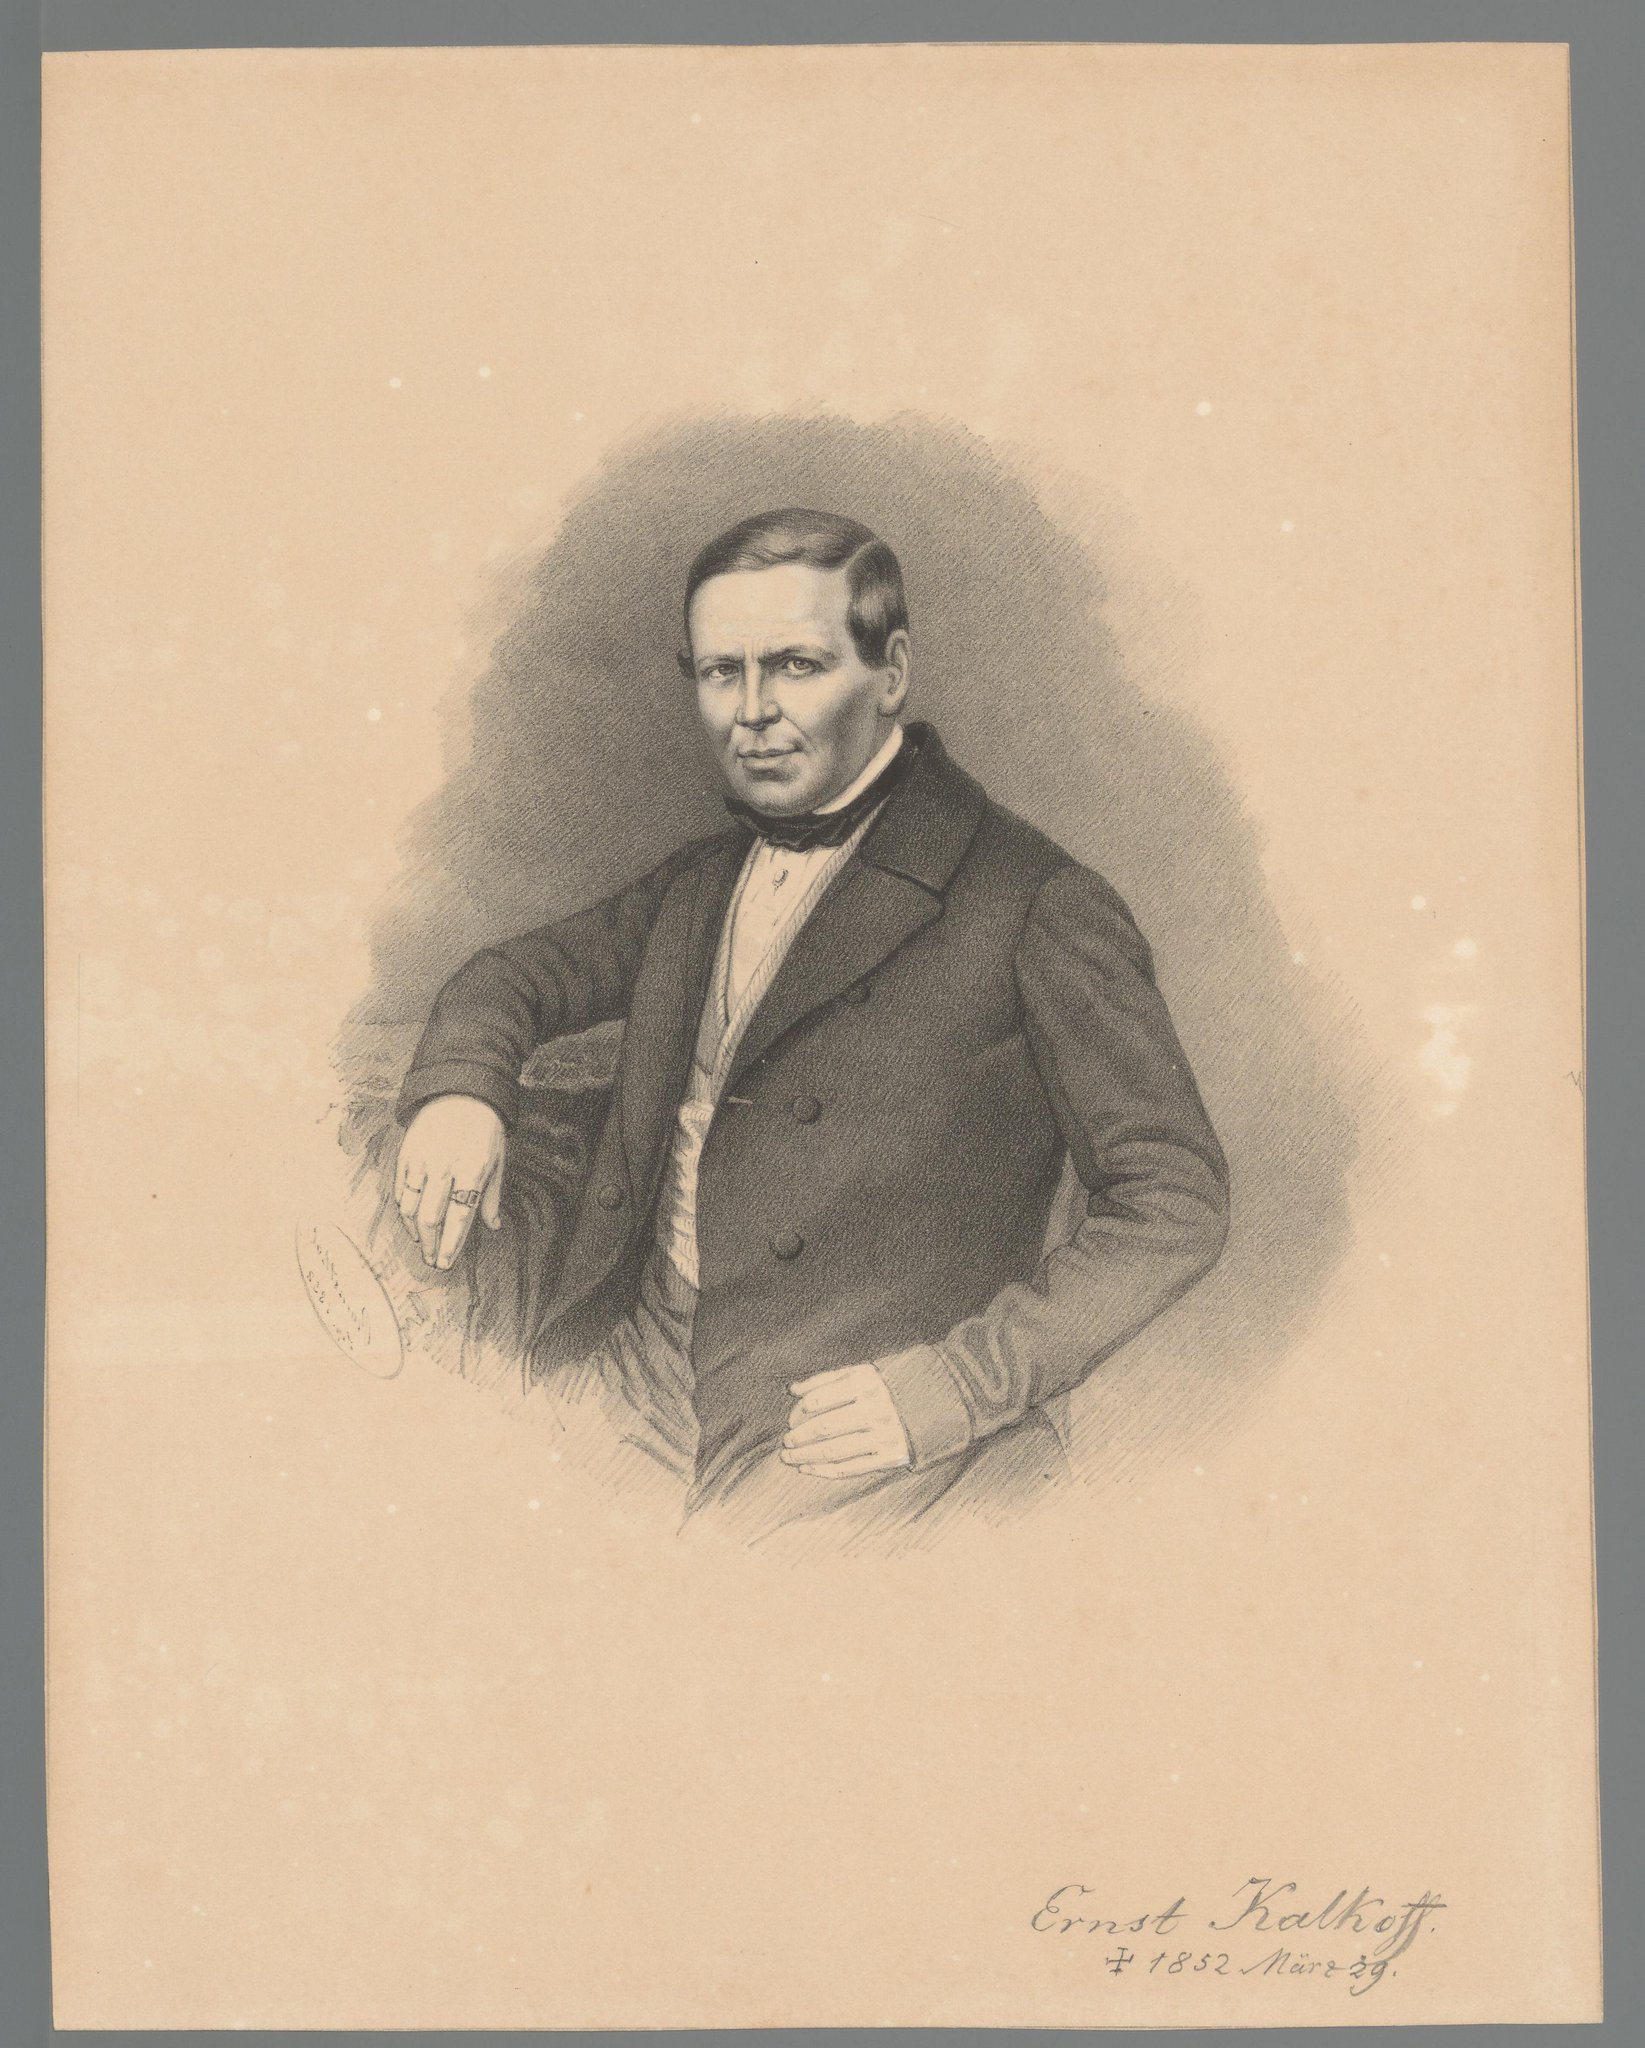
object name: print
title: Portret van Ernst Kalkoff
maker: ramsthal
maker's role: print maker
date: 1852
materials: paper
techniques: lithograph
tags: historical persons not known by name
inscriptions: collector's mark: Lugt 2228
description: Portret van een verder onbekende man met de naam Ernst Kalkoff, gestorven op 29 maart 1852.